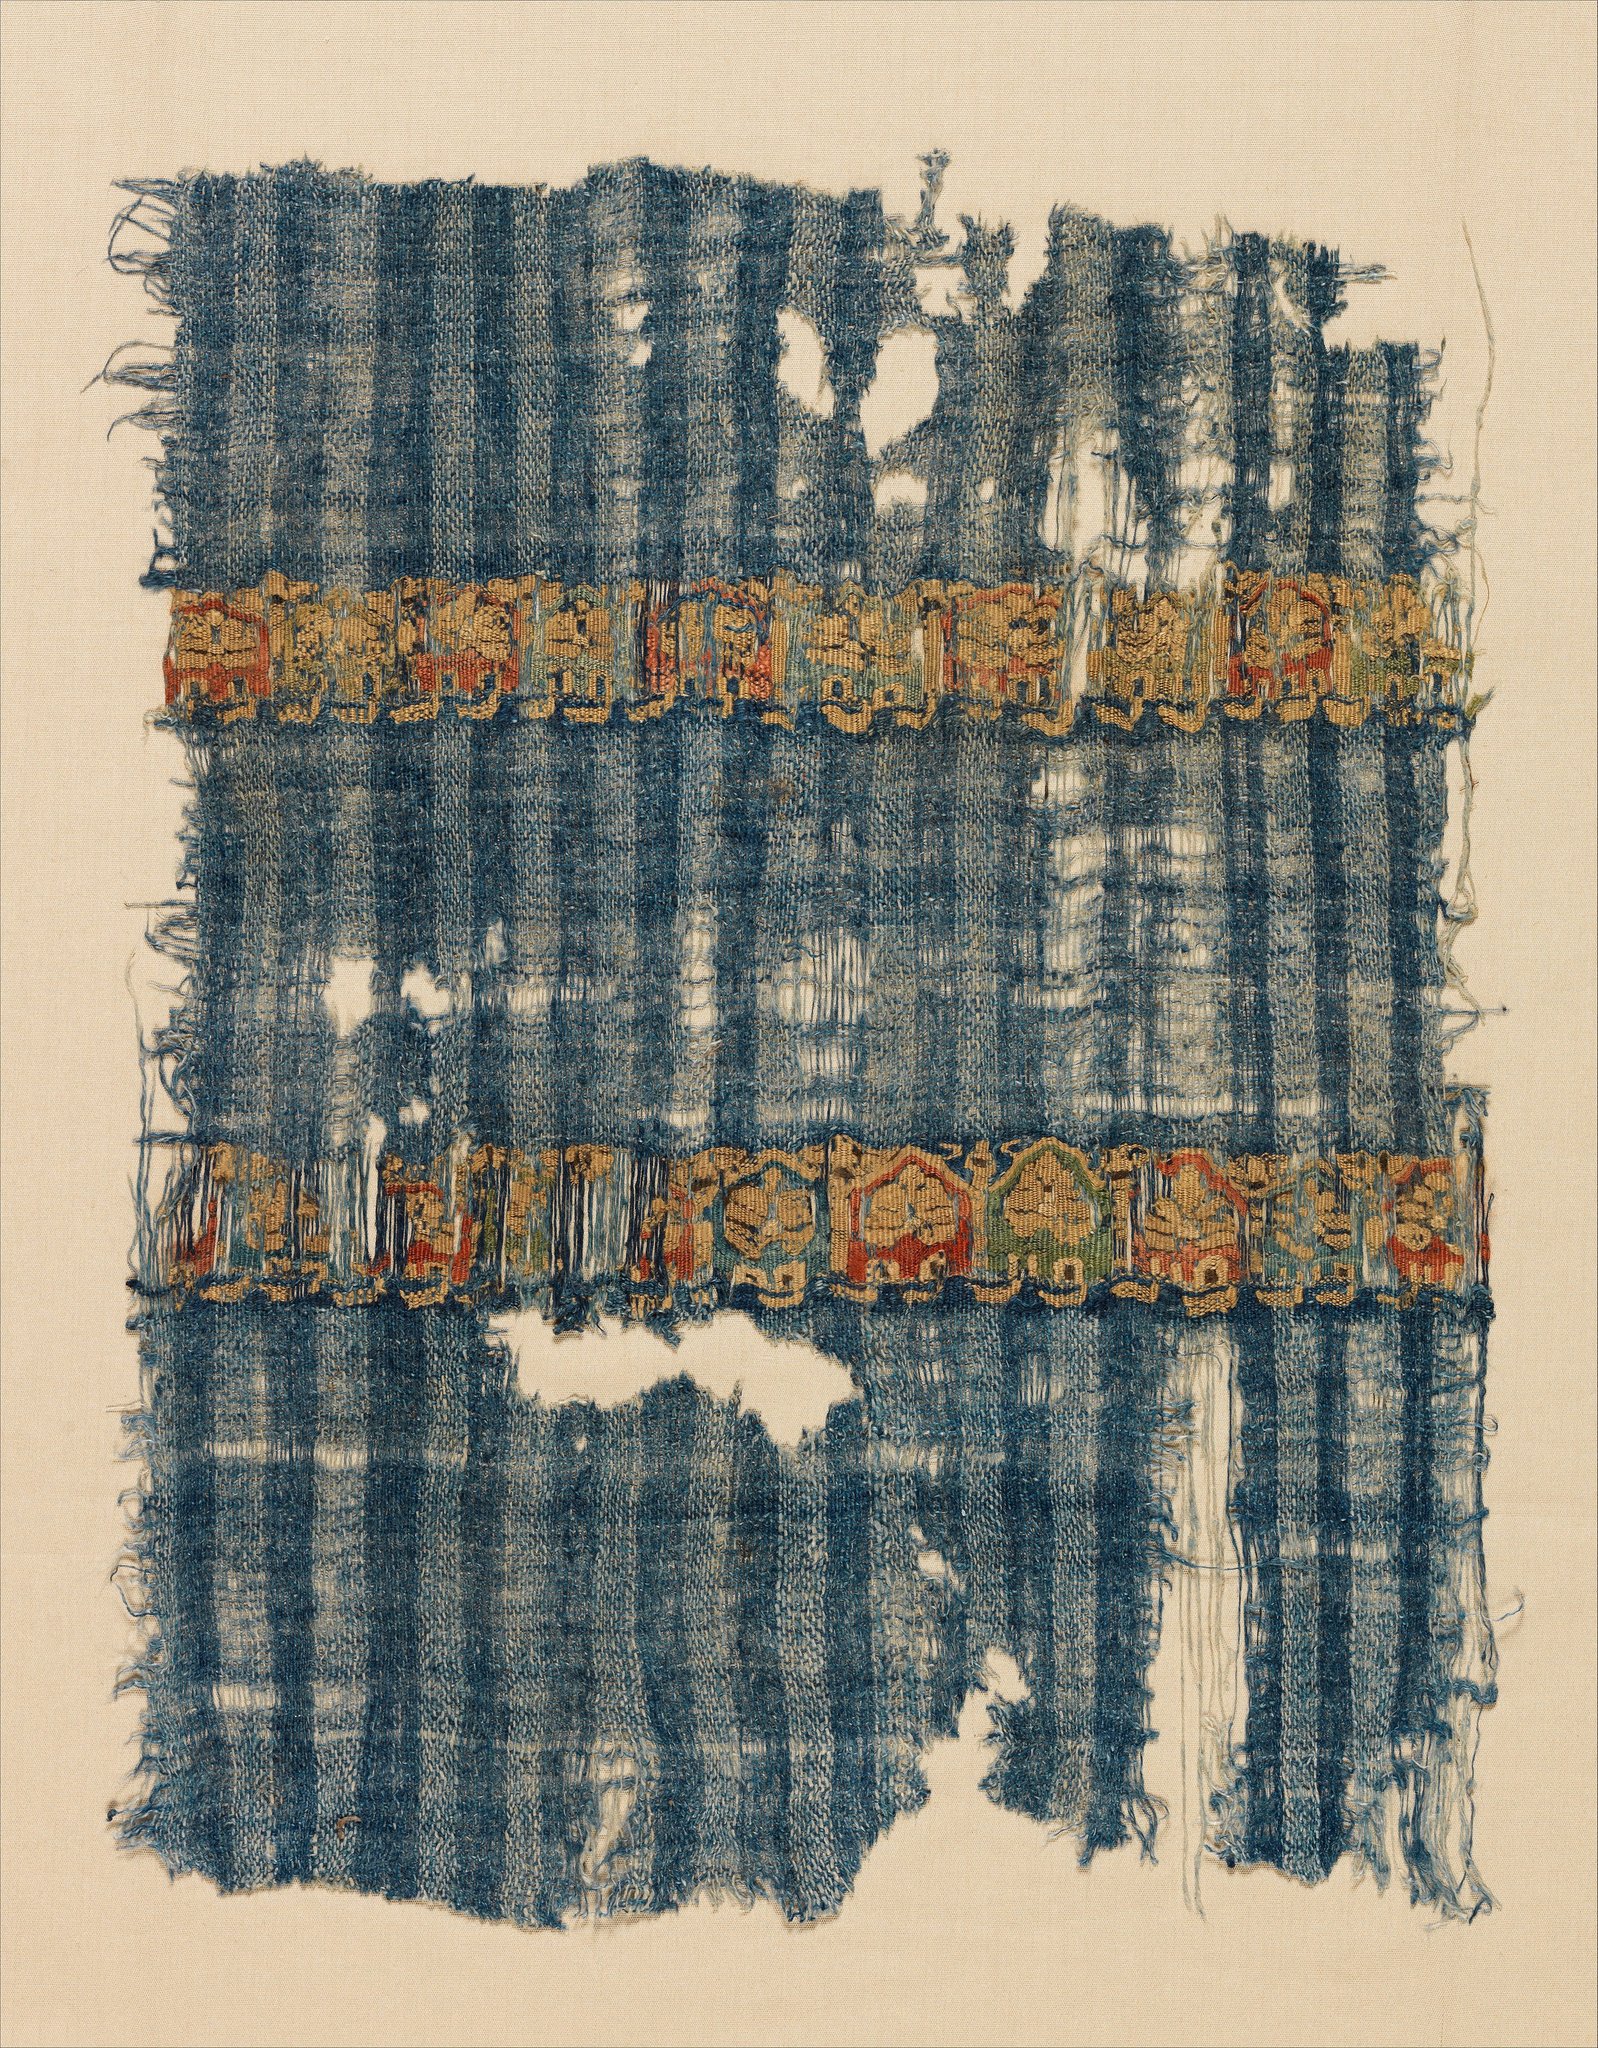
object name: textile fragment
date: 901-1100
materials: linen, silk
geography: egypt